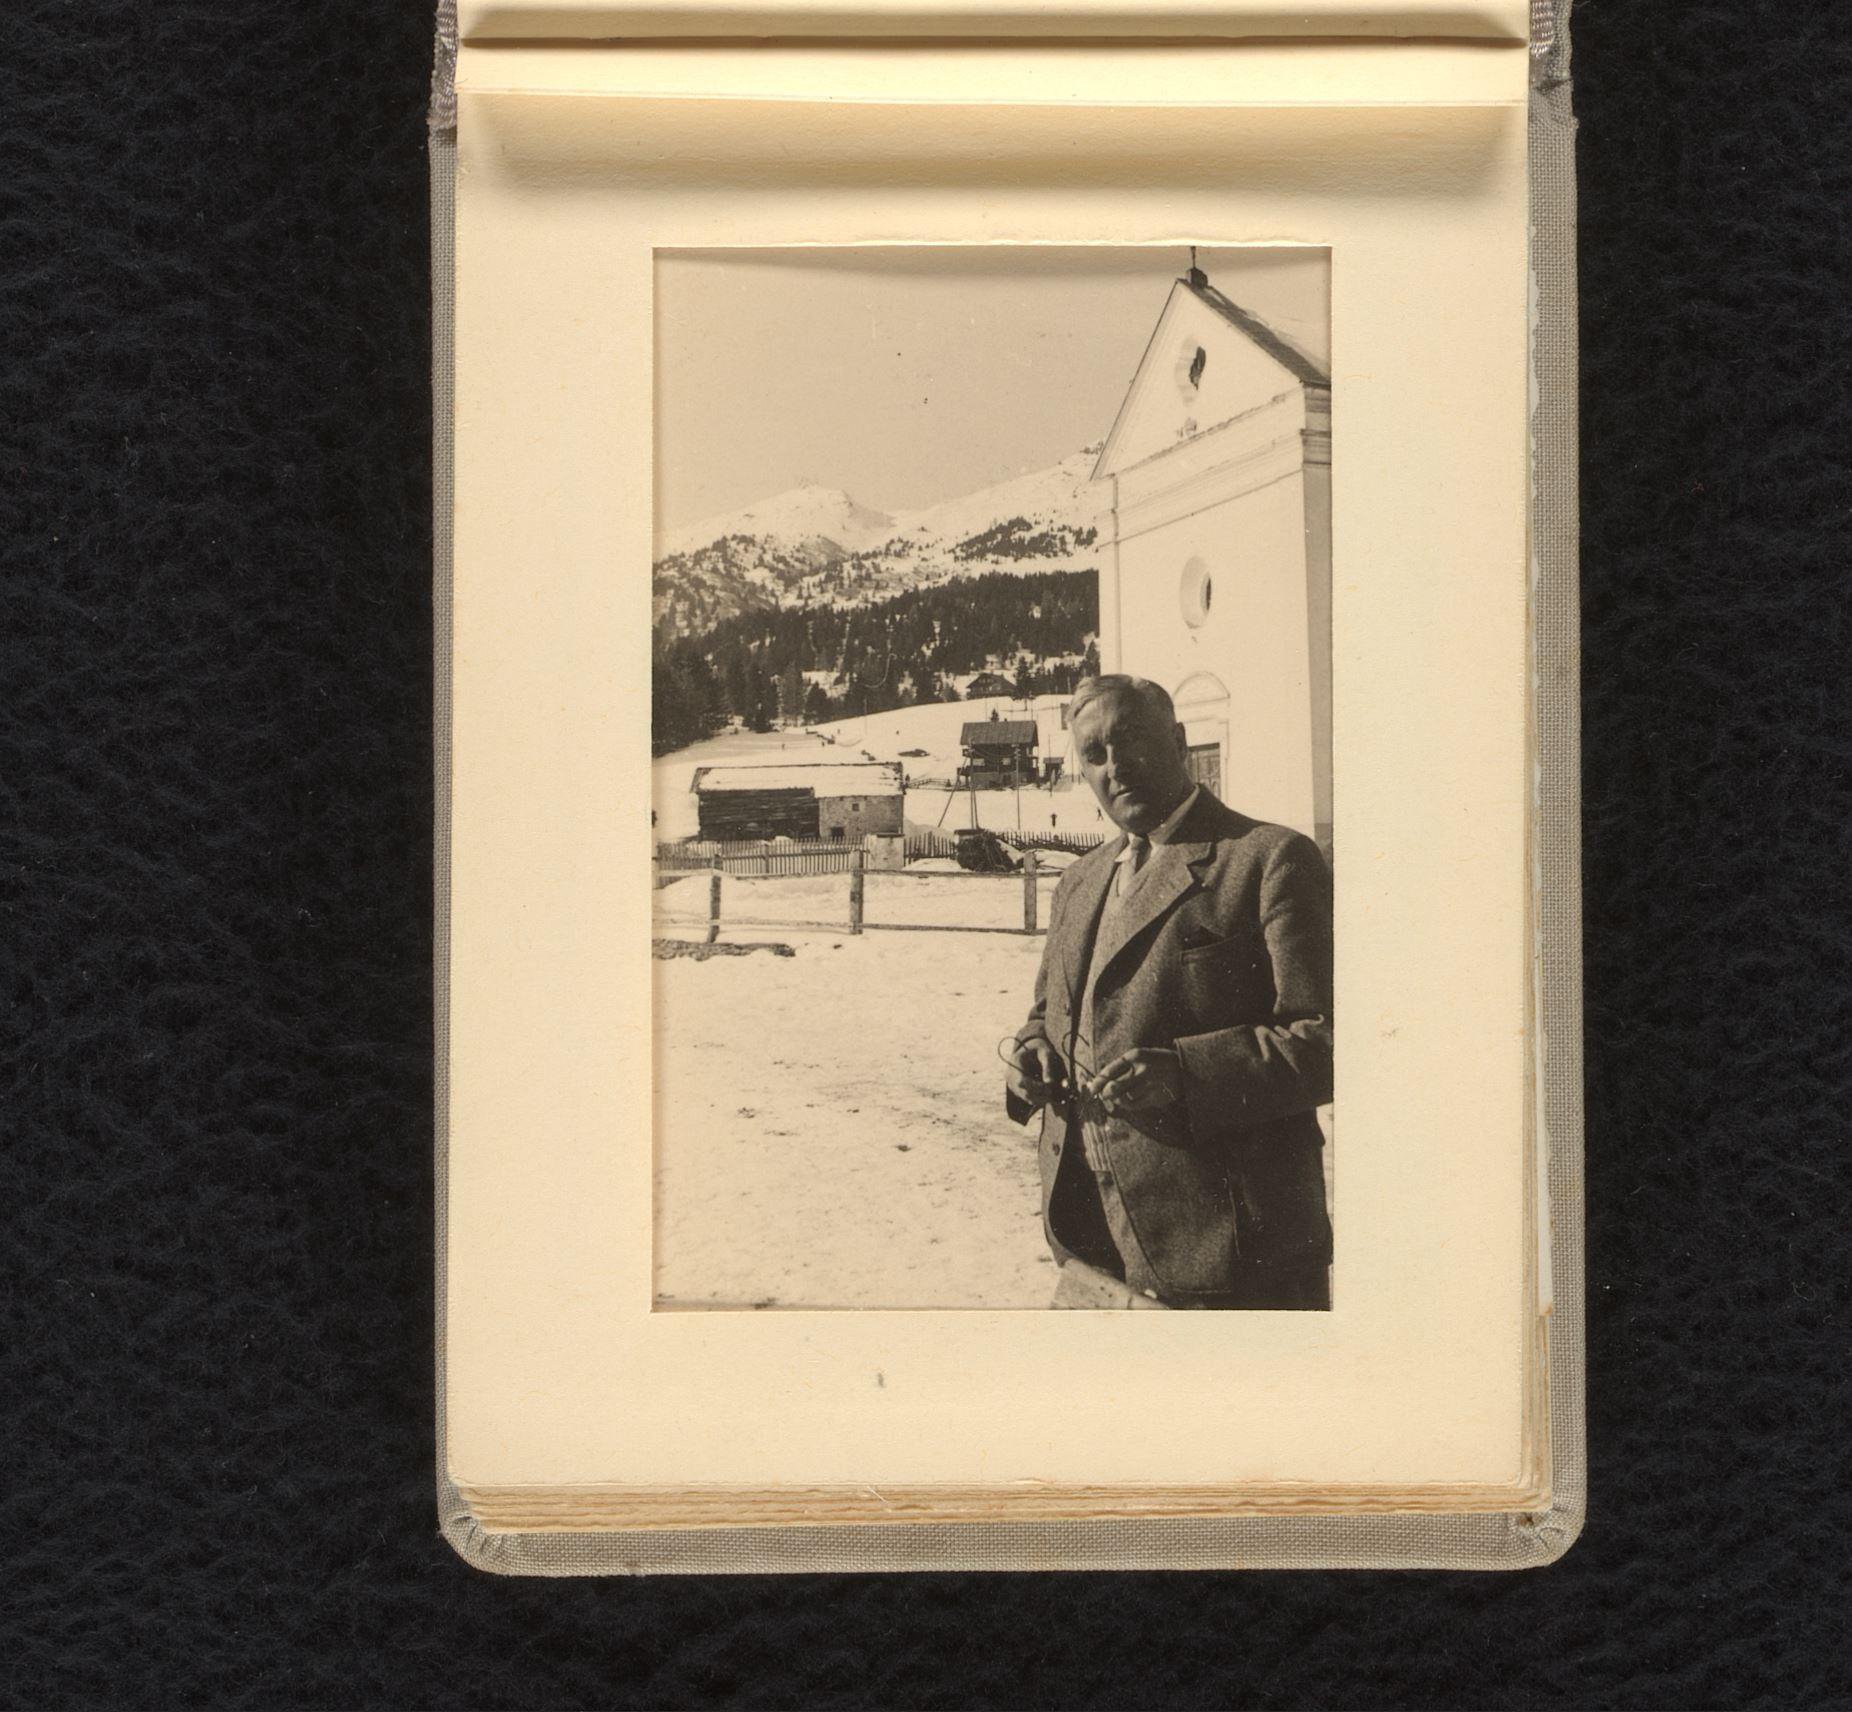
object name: photograph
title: Eugen Wachenheimer voor een kerk in een besneeuwd landschap, 1922-1937, Lenzerheide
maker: isabel wachenheimer-elon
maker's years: 1928-2010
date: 1922-1937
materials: paper, photographic support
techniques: gelatin silver print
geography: lenzerheide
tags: eugen wachenheimer, winter sports, historical persons, church (exterior)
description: Albumblad bevat een foto van Eugen Wachenheimer staande voor de kerk, tijdens een wintersportvakantie in Lenzerheide. Onderdeel van het fotoalbum met diverse foto's van de jeugd van Isabel Wachenheimer voor en tijdens de oorlog en diverse momenten van haar volwassen leven na de Tweede Wereldoorlog.